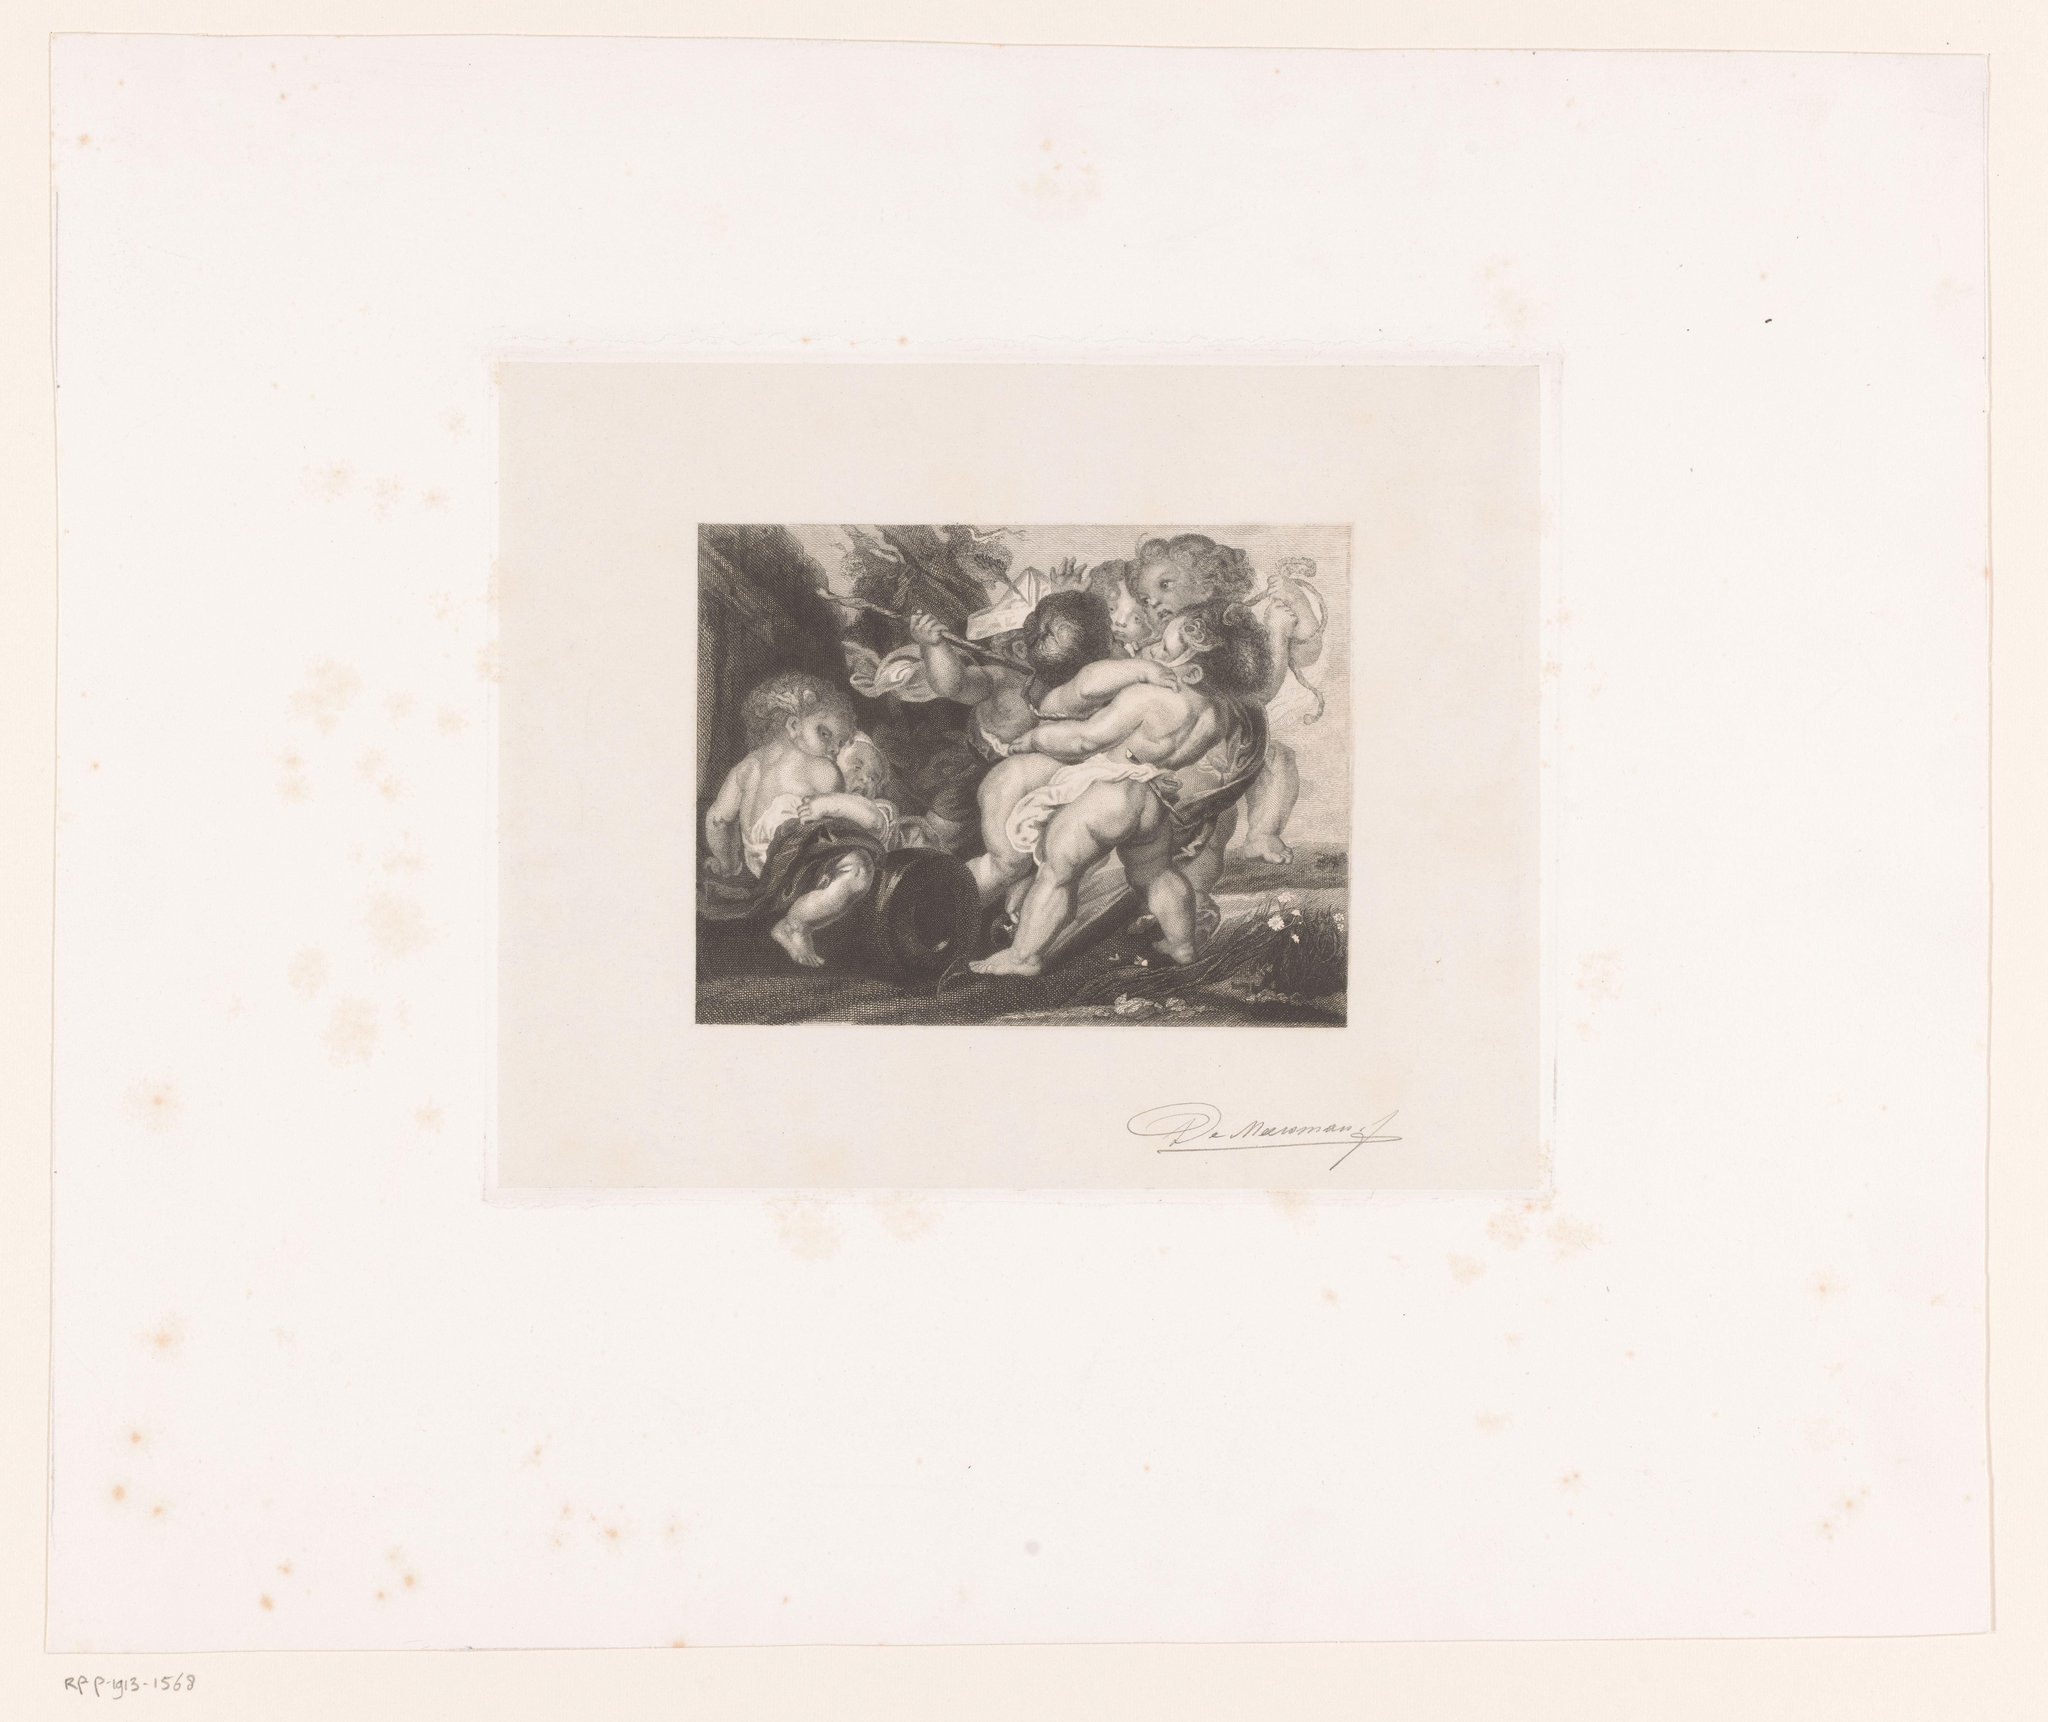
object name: print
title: Vechtende kinderen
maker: françois de meersman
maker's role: print maker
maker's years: 1830-1905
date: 1840-1905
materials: paper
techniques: engraving, etching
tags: rickshaw (+ three persons ~ traffic and transport), fighting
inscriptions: collector's mark: Lugt 2228